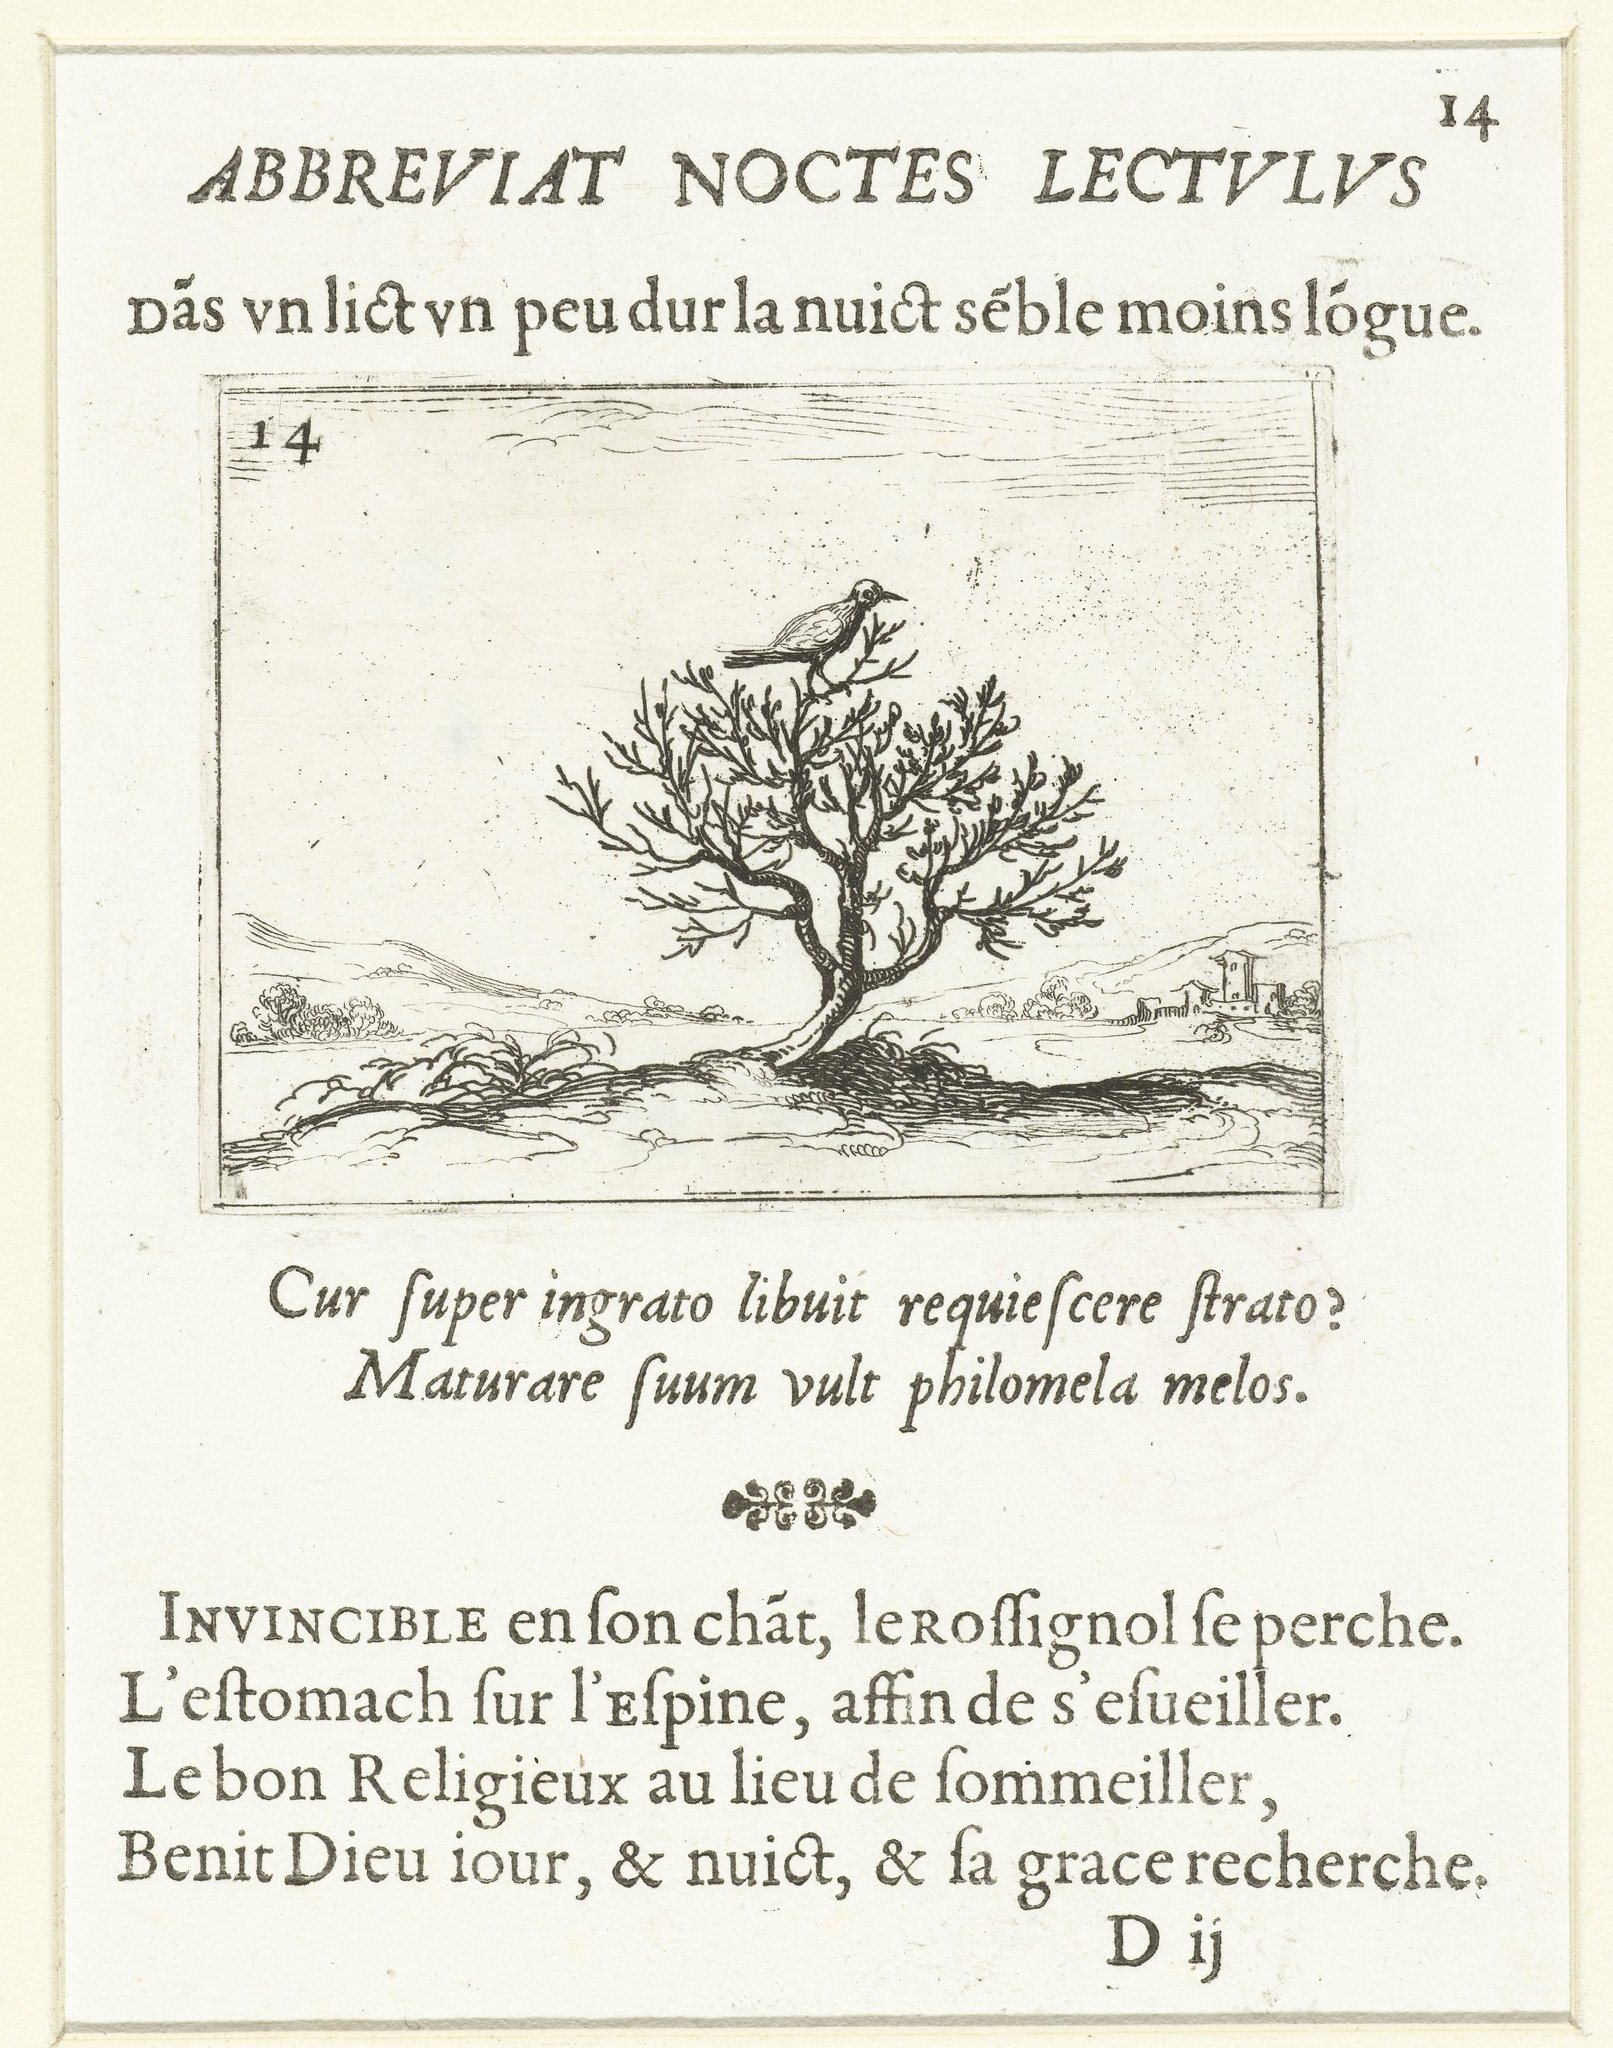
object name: print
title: Kloosterleven in emblemen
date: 1621-1635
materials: paper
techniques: etching, letterpress printing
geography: paris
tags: shrubs, song-birds: nightingale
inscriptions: collector's mark: Lugt 240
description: Voorstelling van een vogel die in een verlaten landschap op een struikje zit. Boven en onder deze prent Latijnse en Franse teksten in boekdruk. Dit blad is onderdeel van de embleemserie 'Kloosterleven in emblemen'. De tweede staat van deze serie behelst naast een geïllustreerde titelpagina en 26 emblemen nog een titelpagina en een blad met opdracht, beide in boekdruk zonder afbeelding.